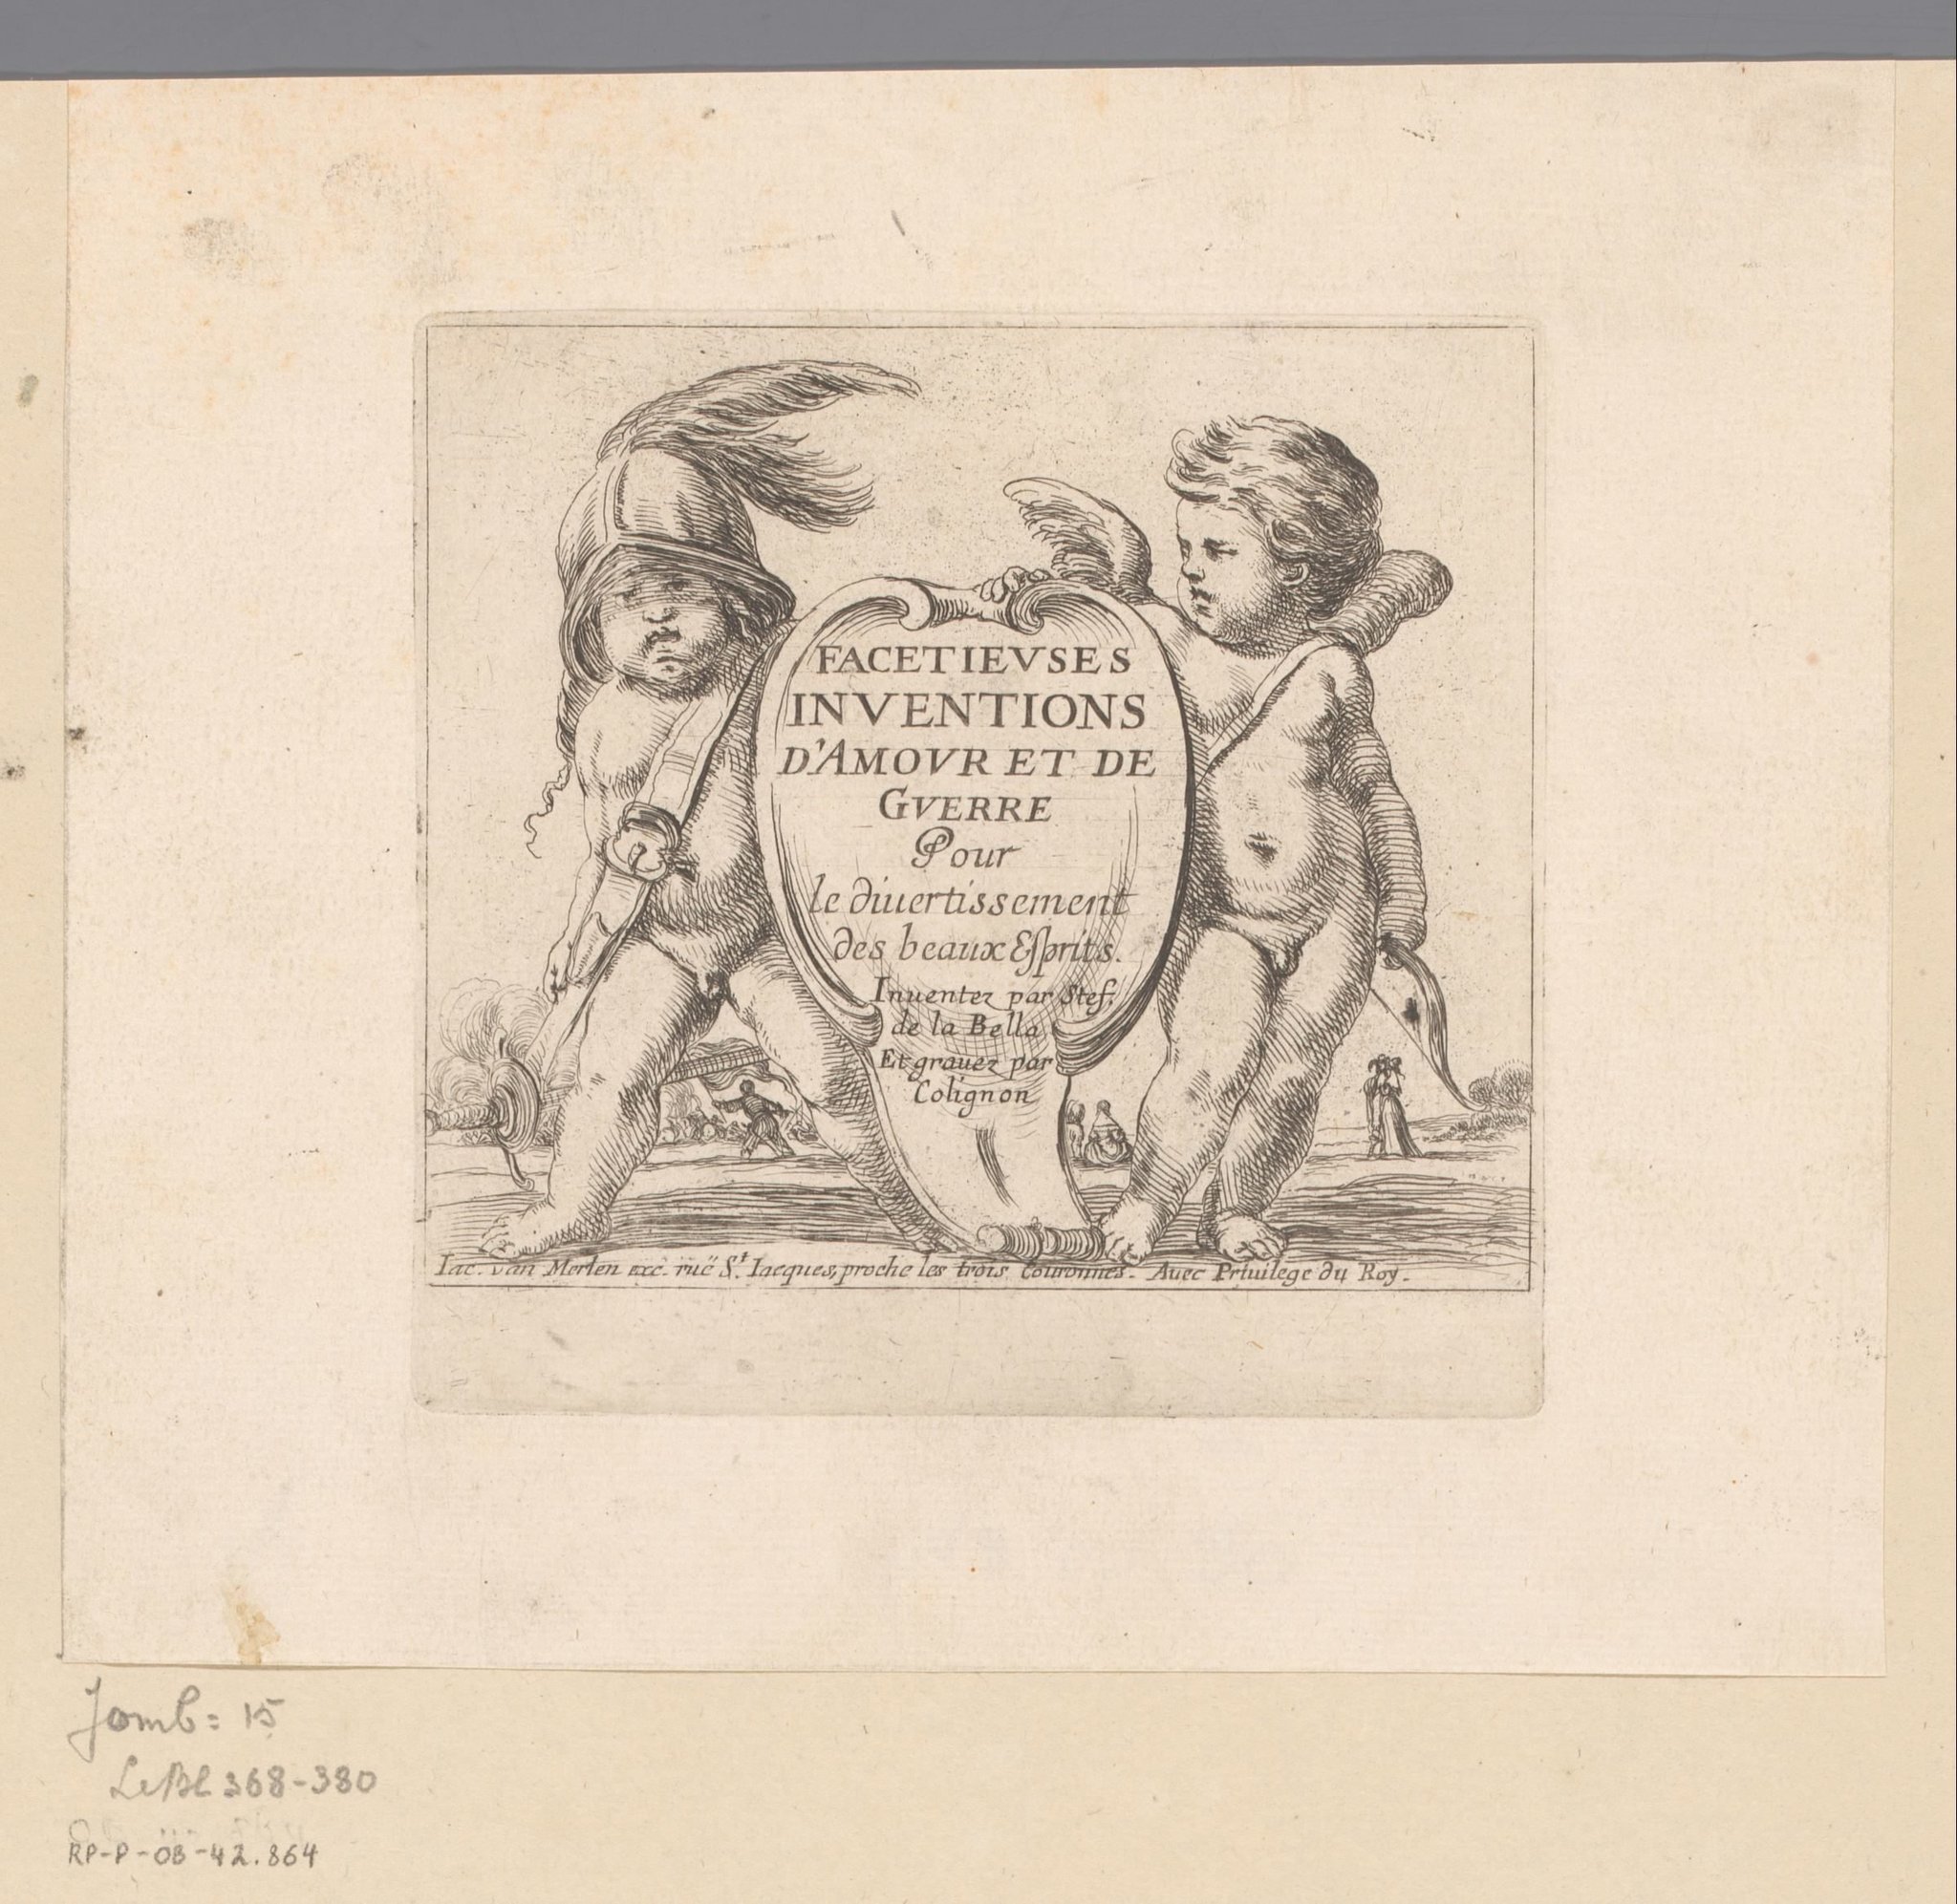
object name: titelprent, frontispice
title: Facetieuses Inventions d'amour et de guerre. Pour le divertissement des beaux Esprits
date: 1620-1657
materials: paper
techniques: engraving, etching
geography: paris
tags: helmet, cupids: 'amores', 'amoretti', 'putti'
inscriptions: collector's mark: Lugt 240